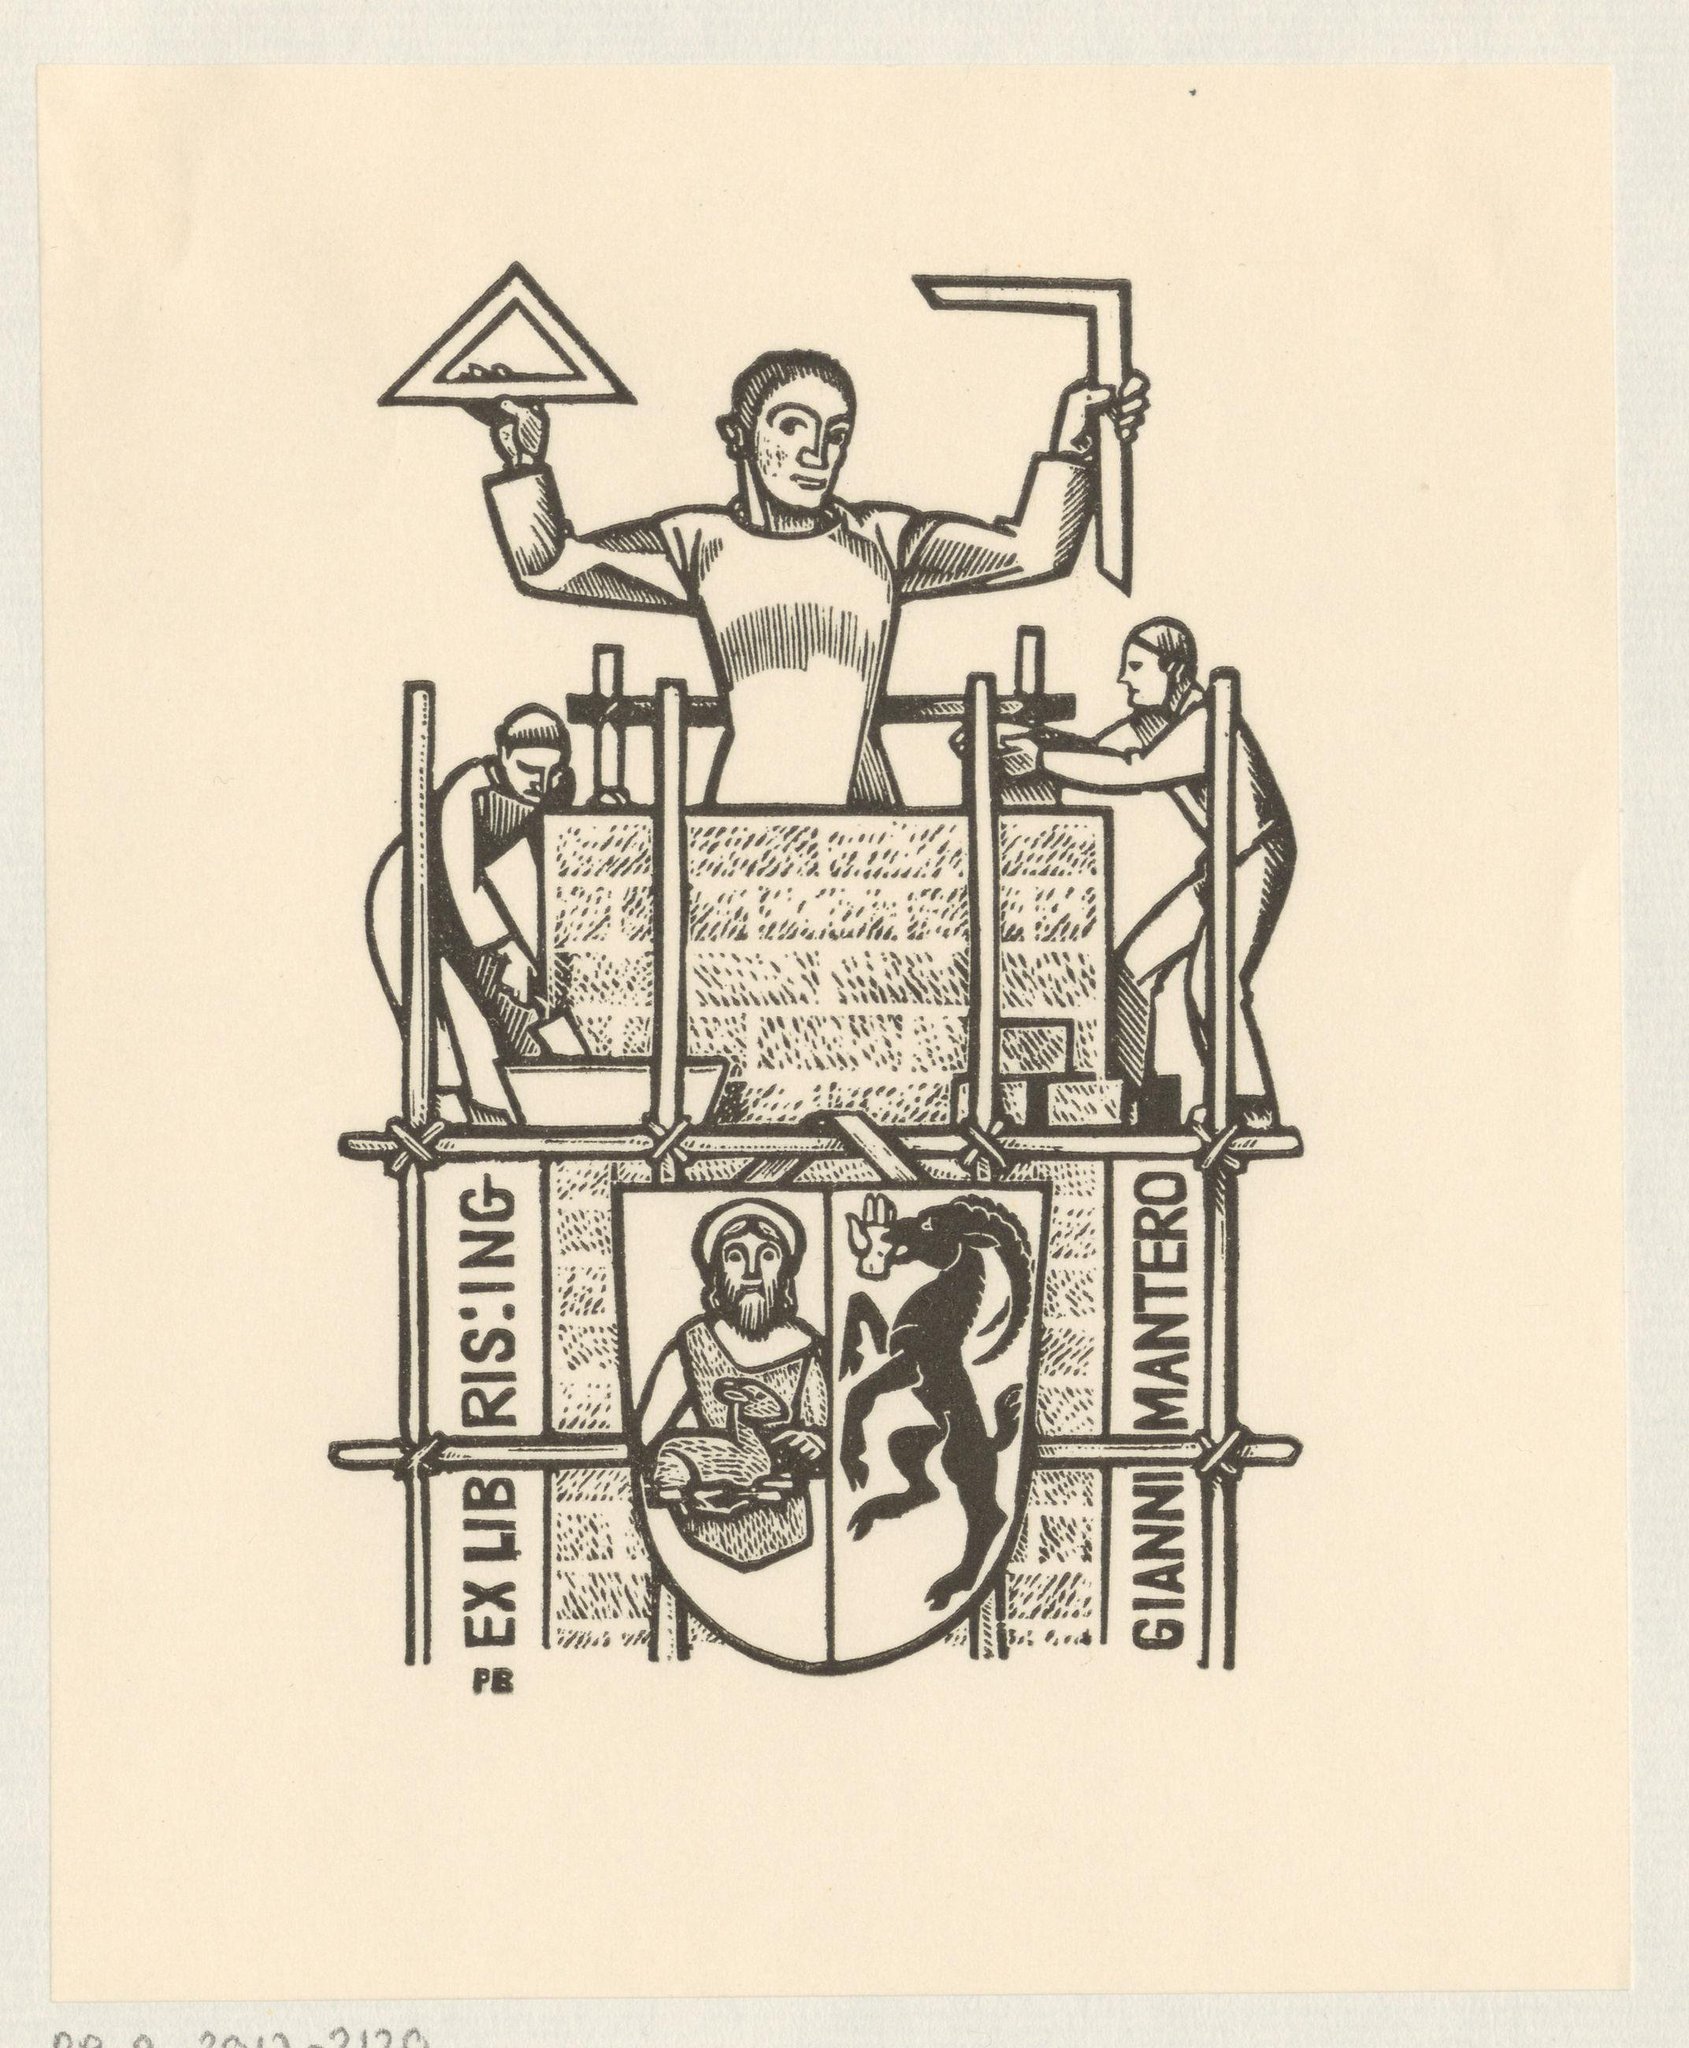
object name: bookplate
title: Ex libris van Gianni Mantero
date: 1930-1950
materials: paper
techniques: printing block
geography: italy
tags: engineer, gianni mantero, architect at work, christ as good shepherd, armorial bearing, heraldry, tools, implements of architect